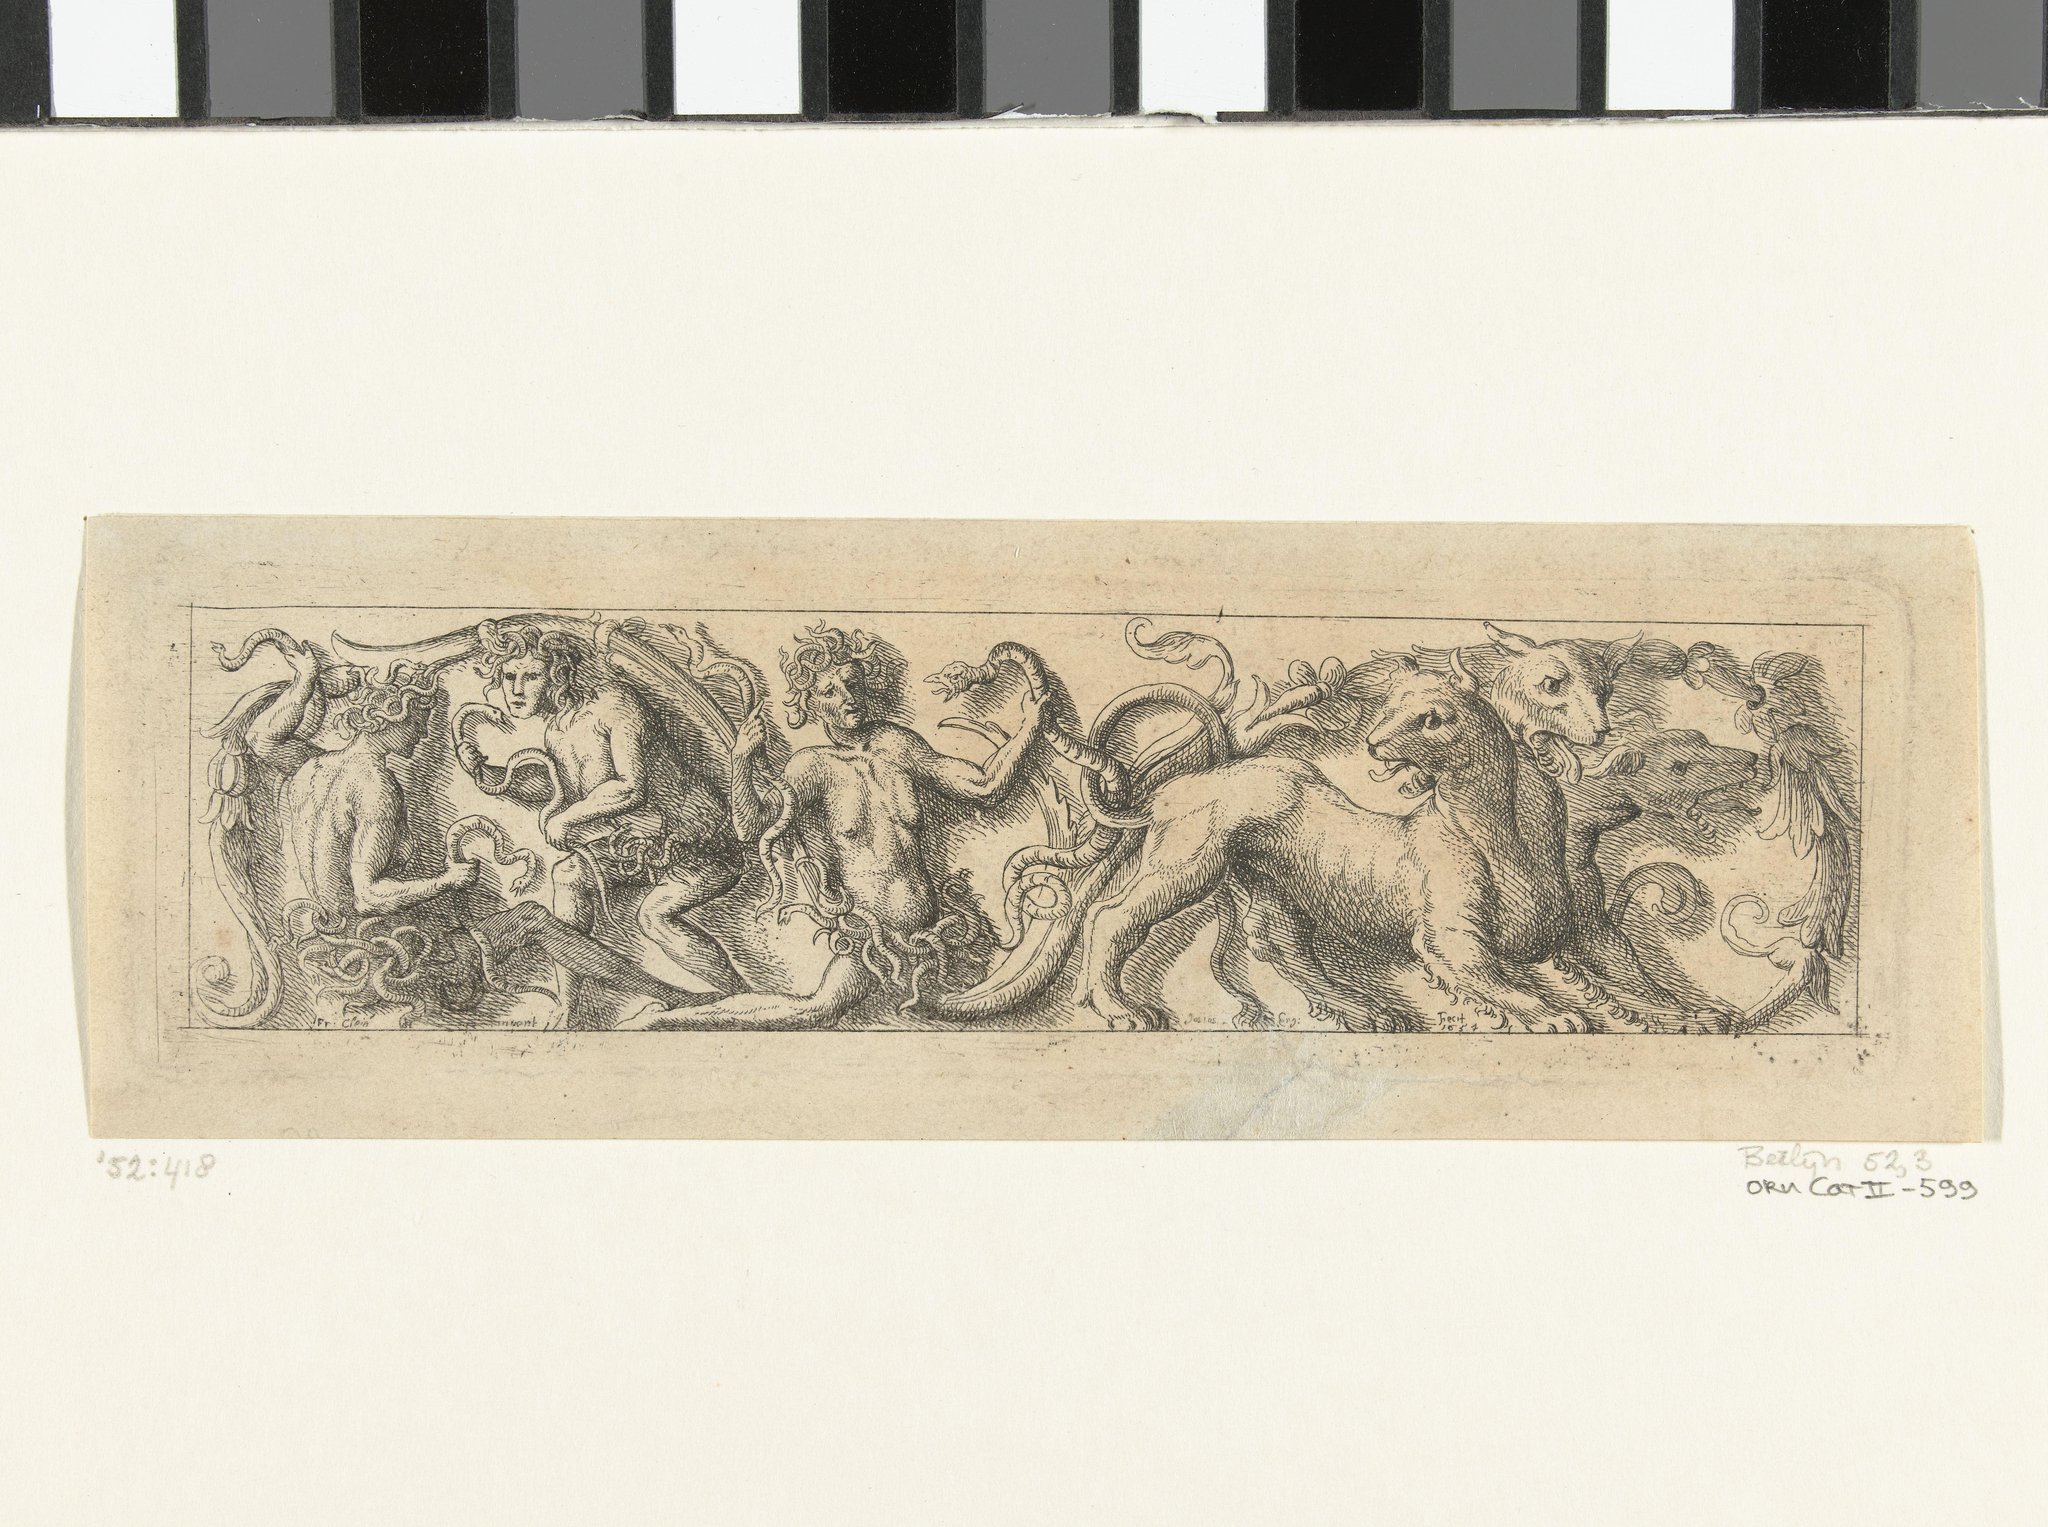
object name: ornament print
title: Drie Furiën en Cerberus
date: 1654-1657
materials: paper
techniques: etching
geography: london